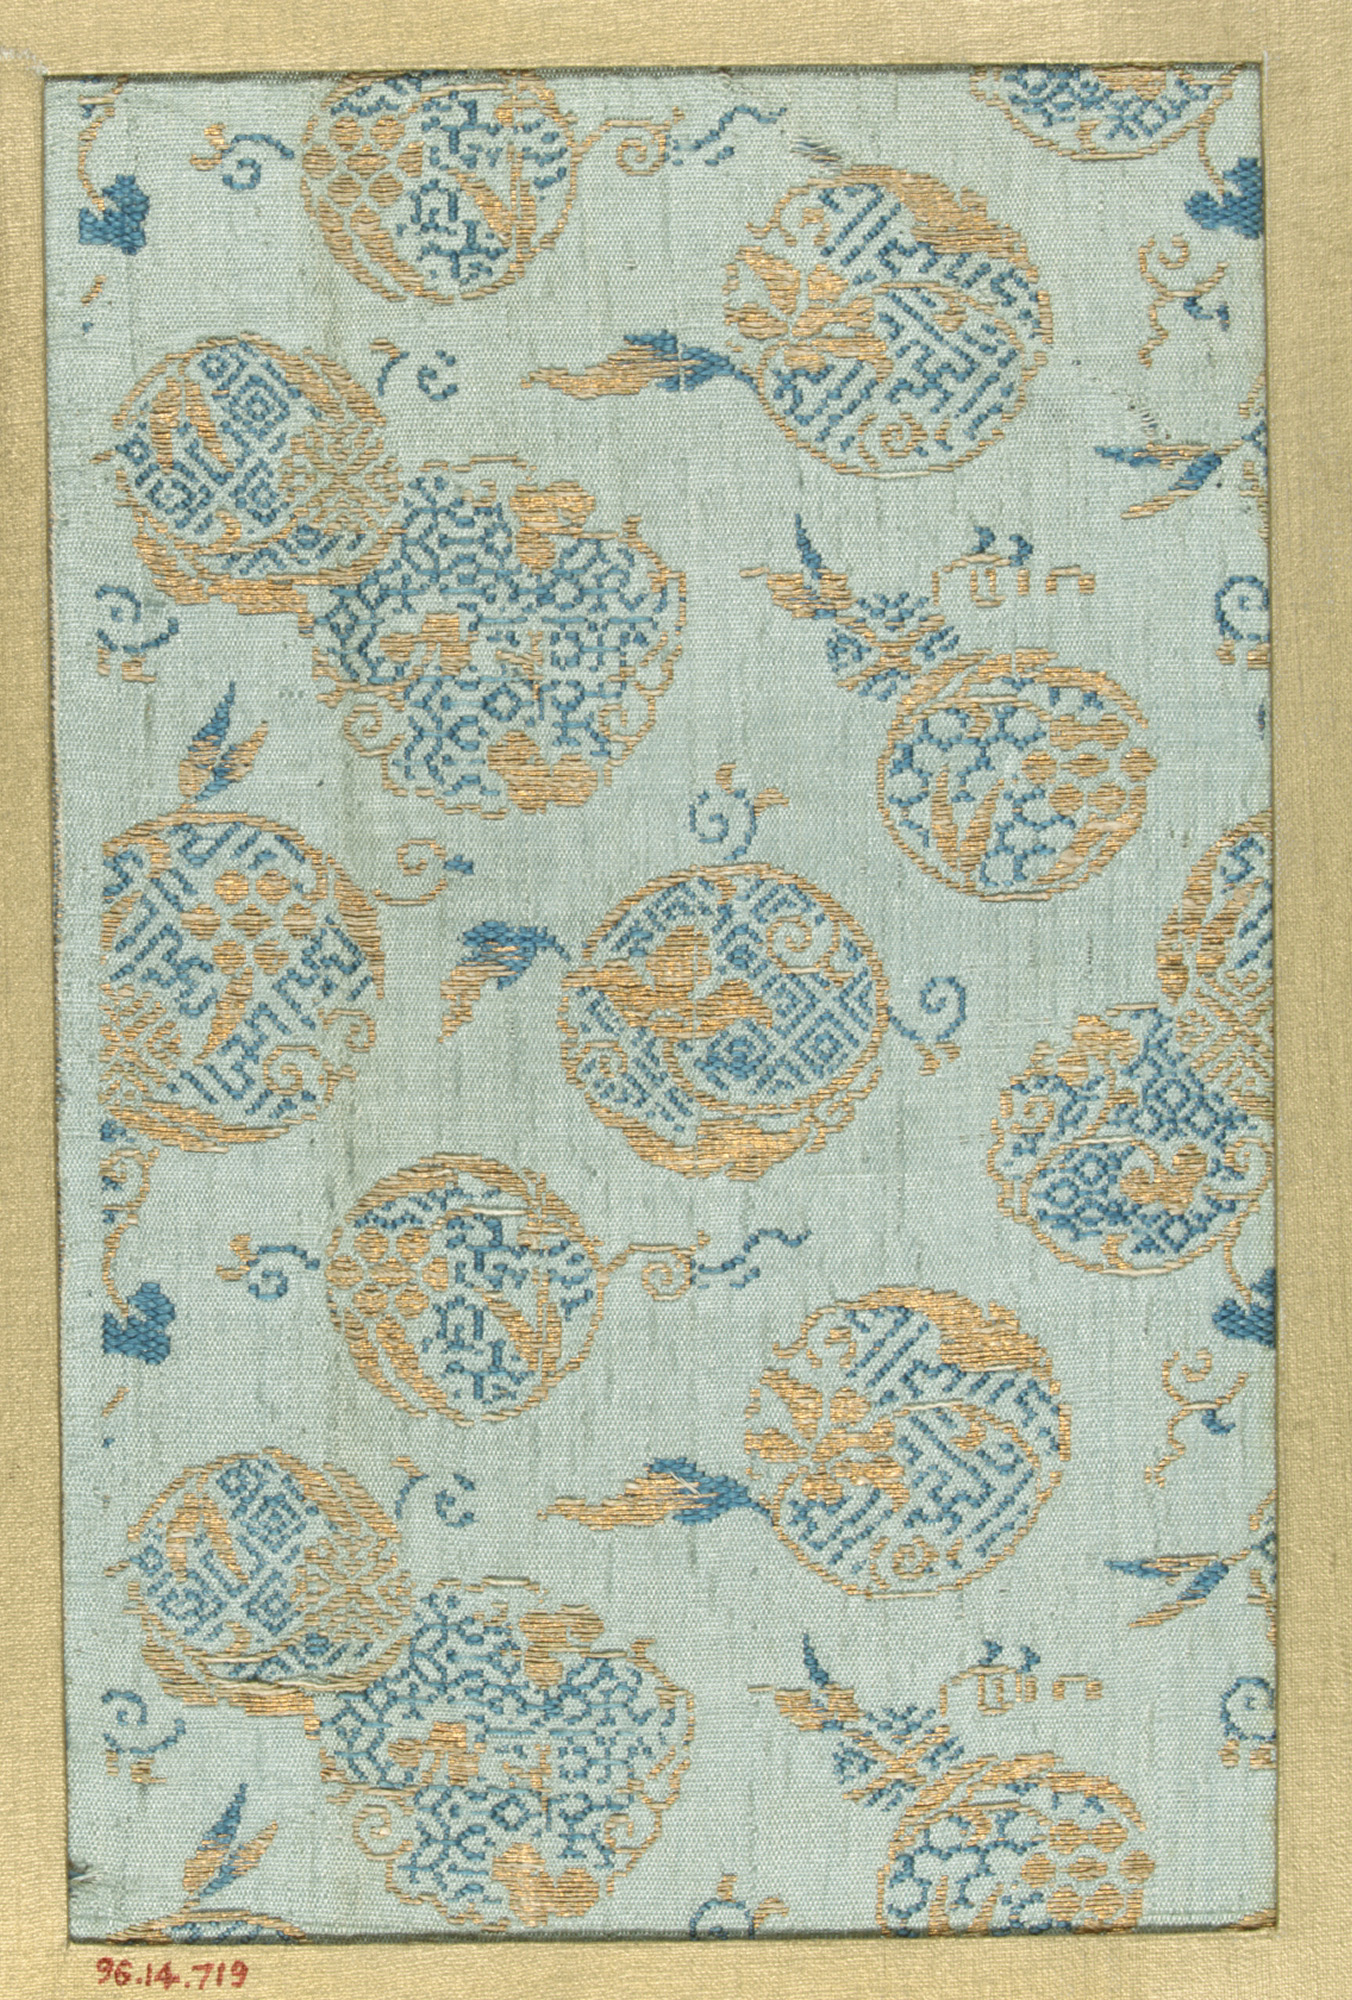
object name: piece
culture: japanese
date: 1701-1900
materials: silk